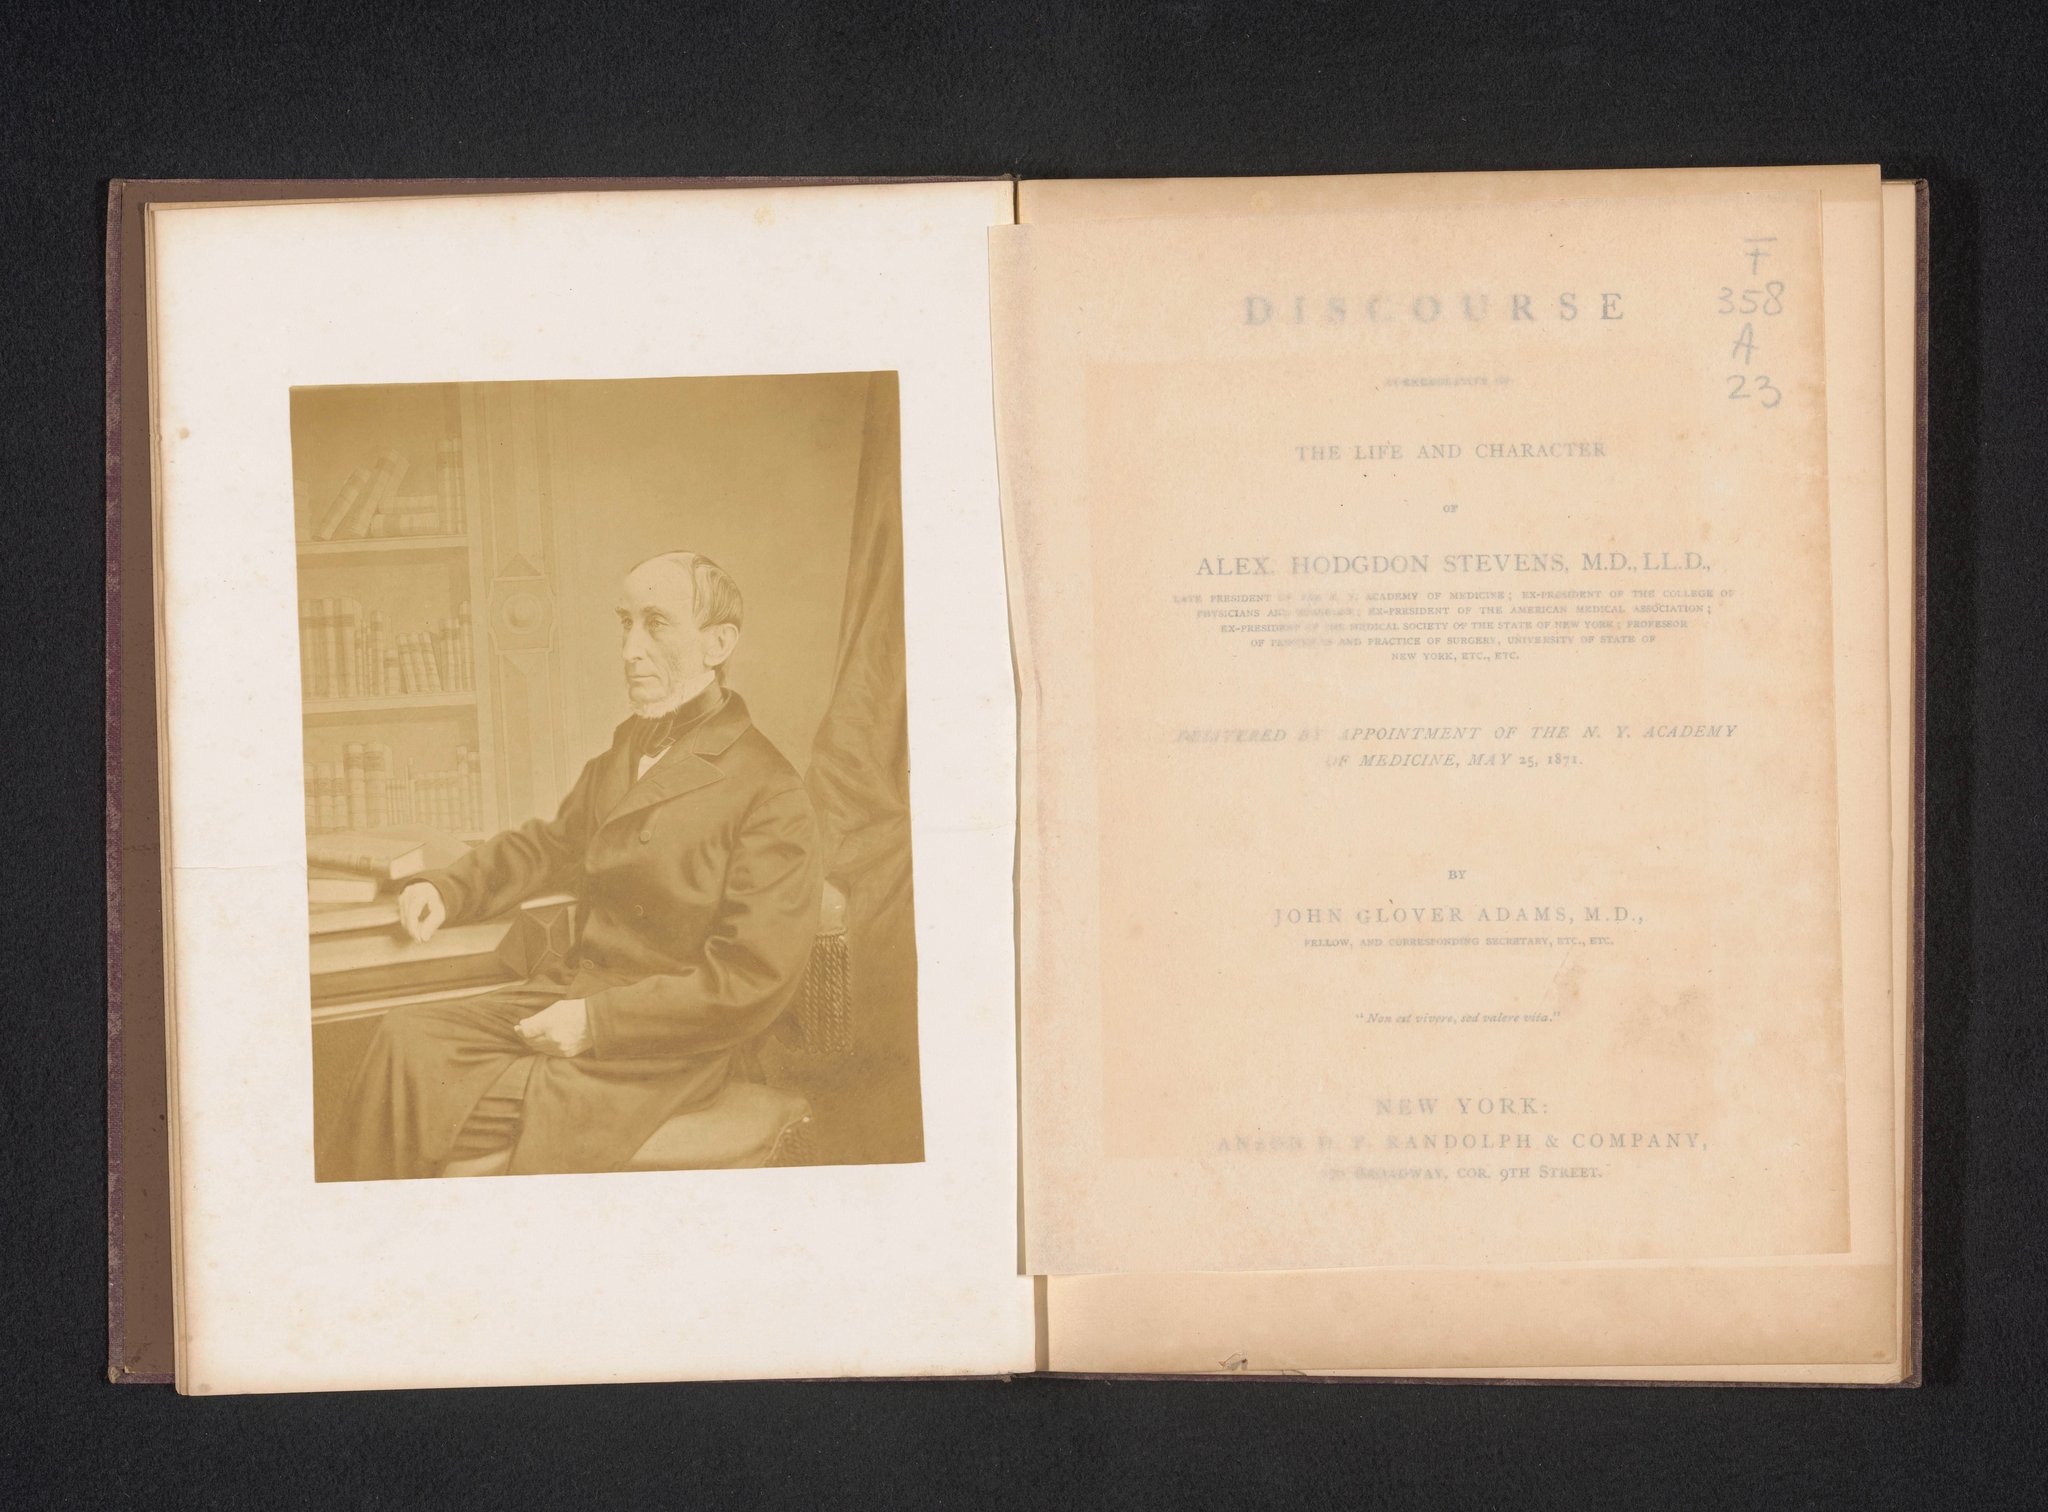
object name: photograph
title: Portret van Alexander Hodgdon Stevens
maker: Anonymous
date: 1866-1871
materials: photographic support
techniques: albumen print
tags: historical persons